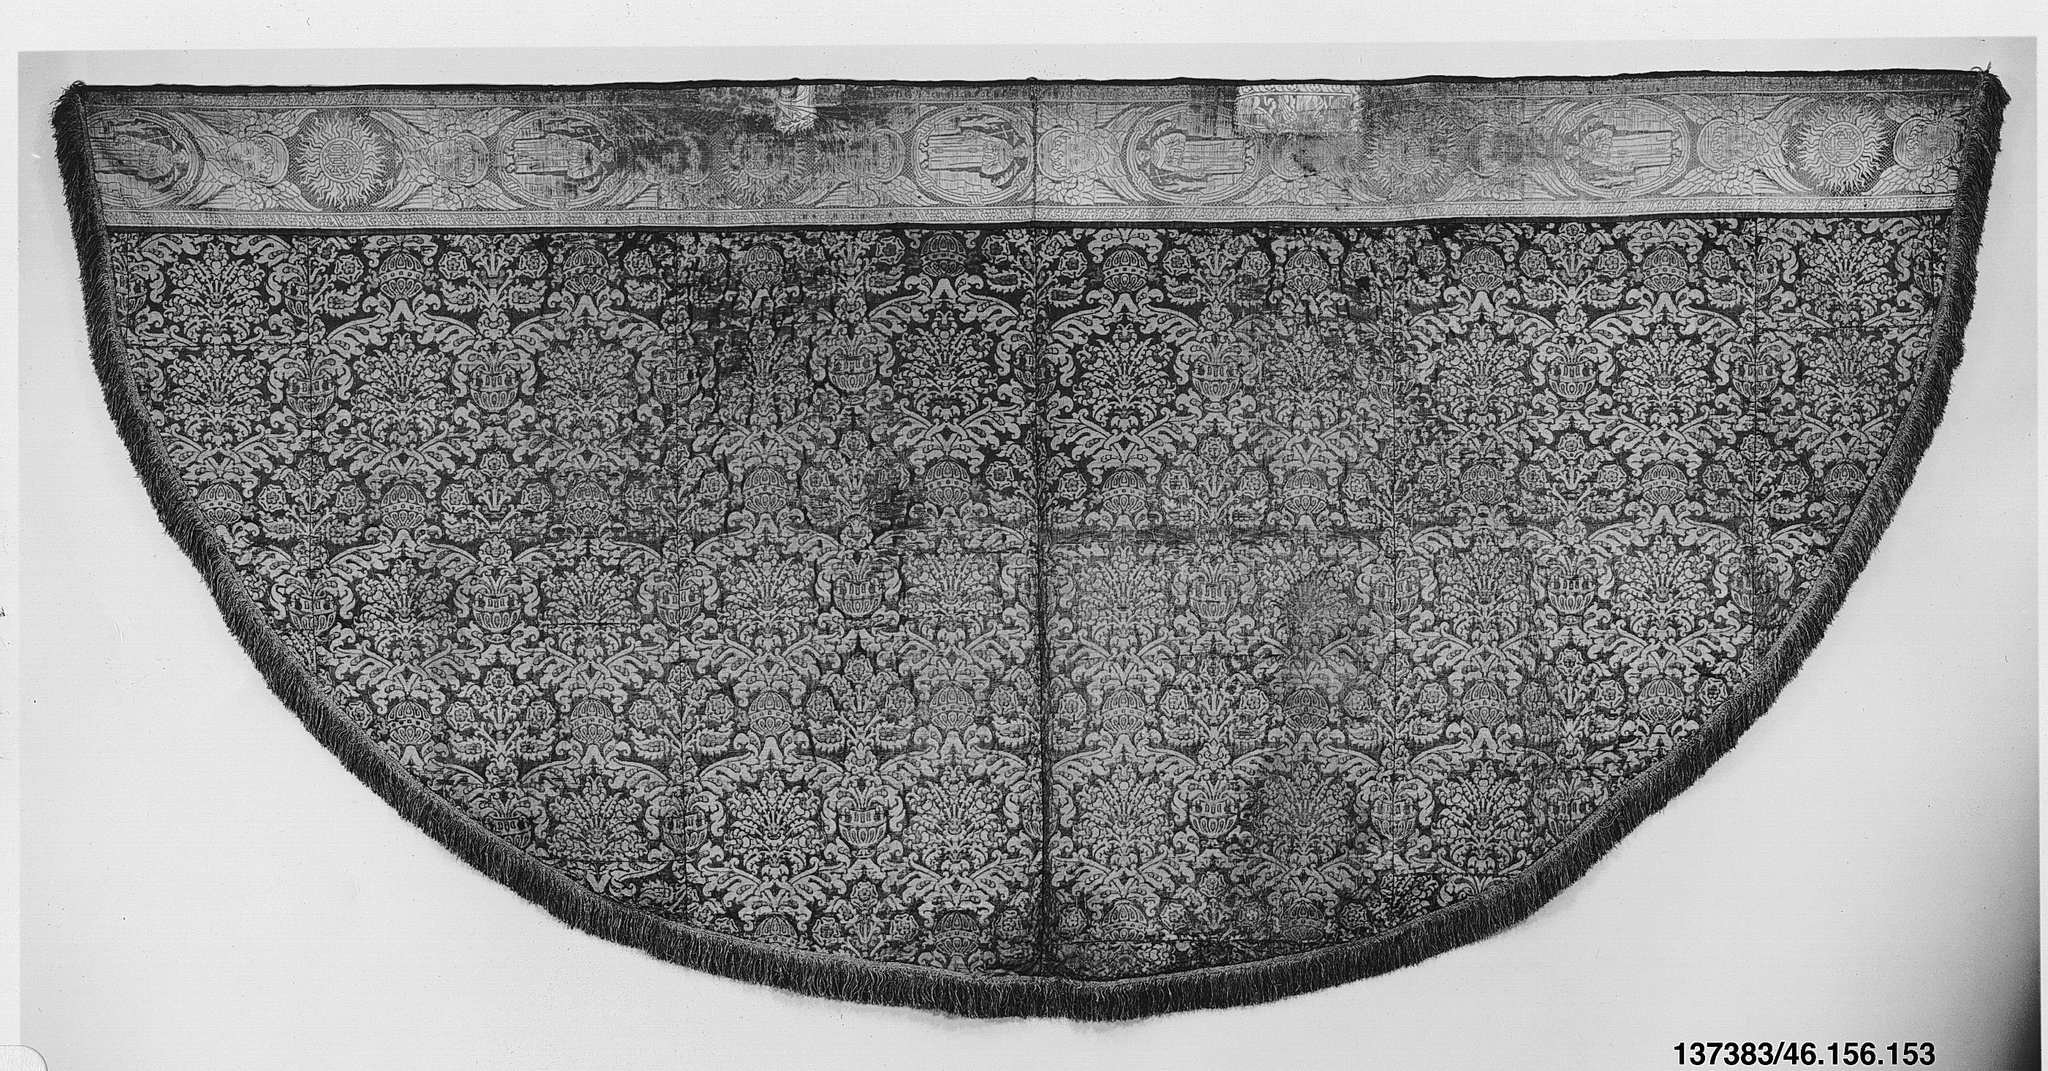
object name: cope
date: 1534-1566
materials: silk